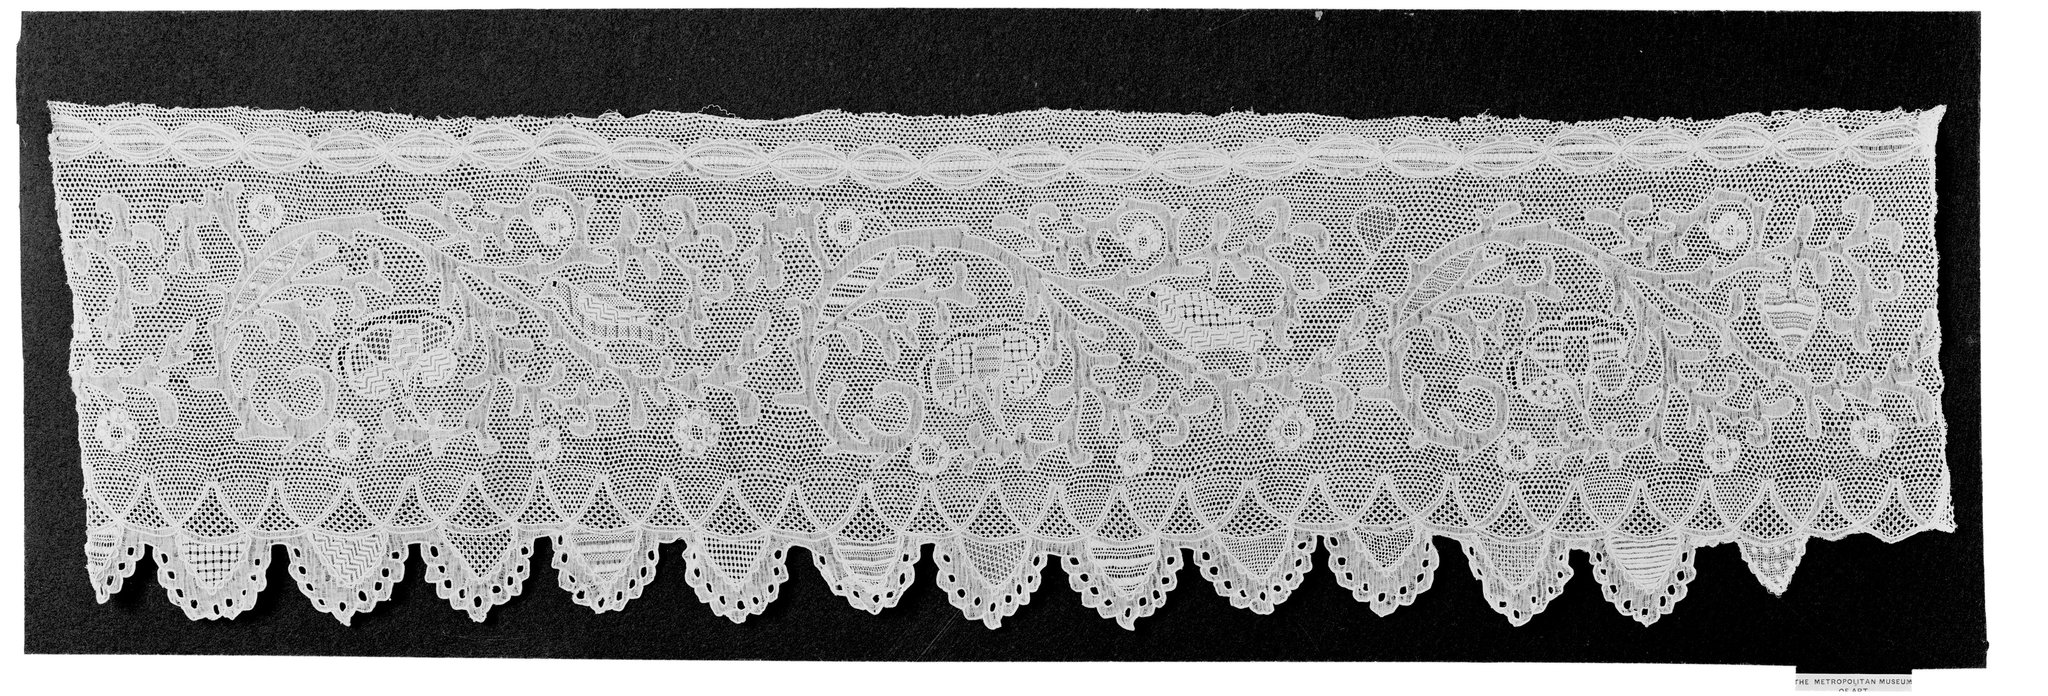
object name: scroll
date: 1701-1900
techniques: embroidery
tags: birds,flowers